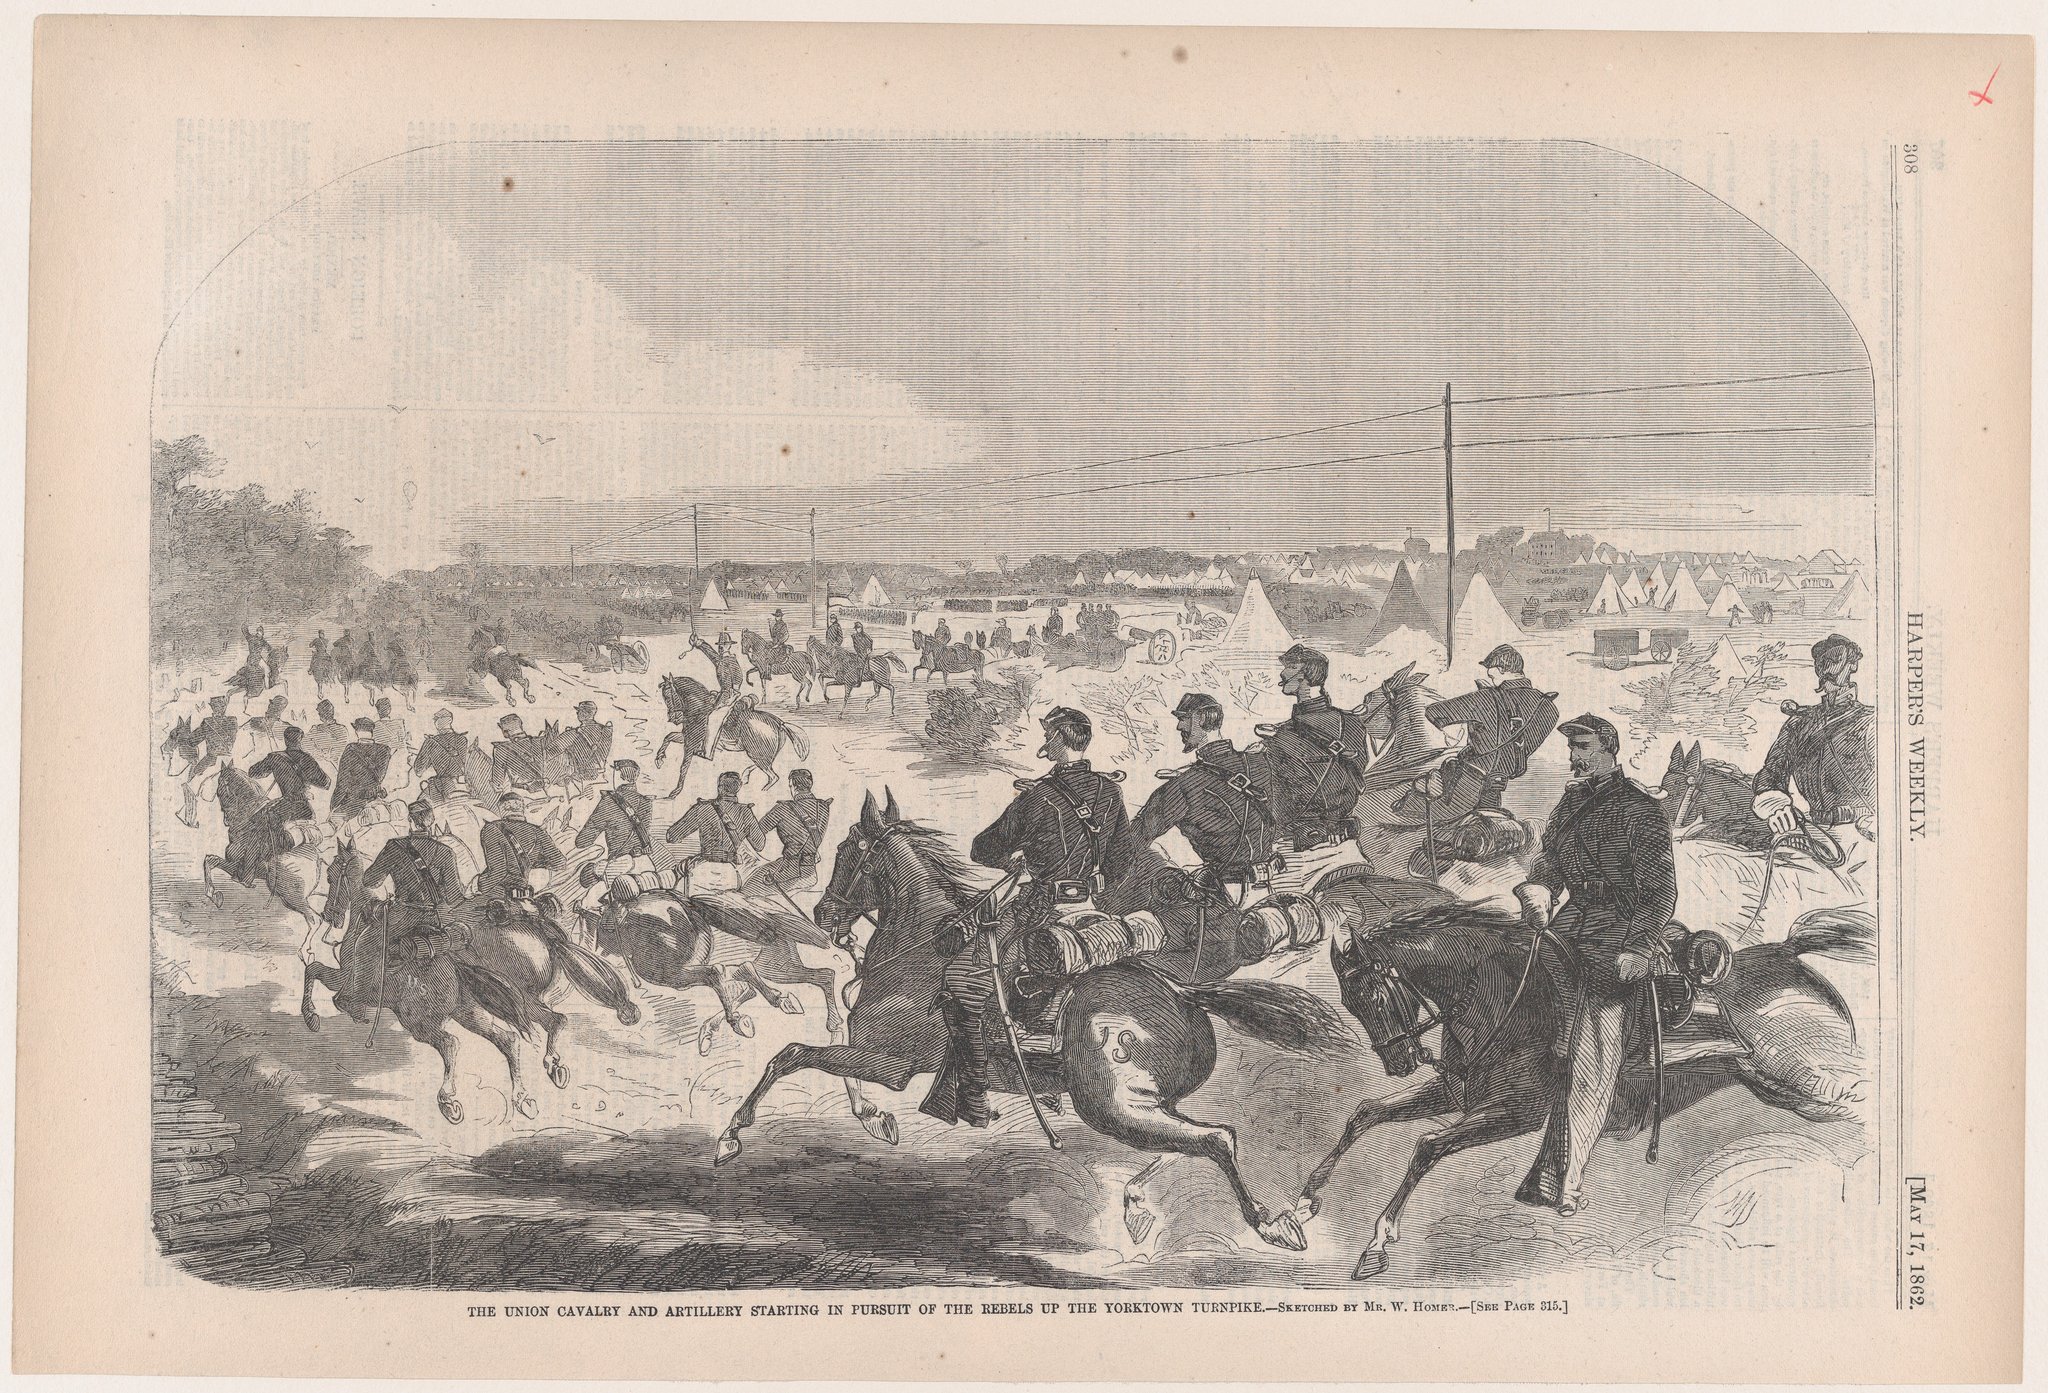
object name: print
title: The Union Cavalry and Artillery Starting in Pursuit of the Rebels up the Yorktown Turnpike (from "Harper's Weekly," Vol. VI)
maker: winslow homer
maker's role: artist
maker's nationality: american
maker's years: 1836-1910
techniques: engraving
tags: army,american civil war,men,horses